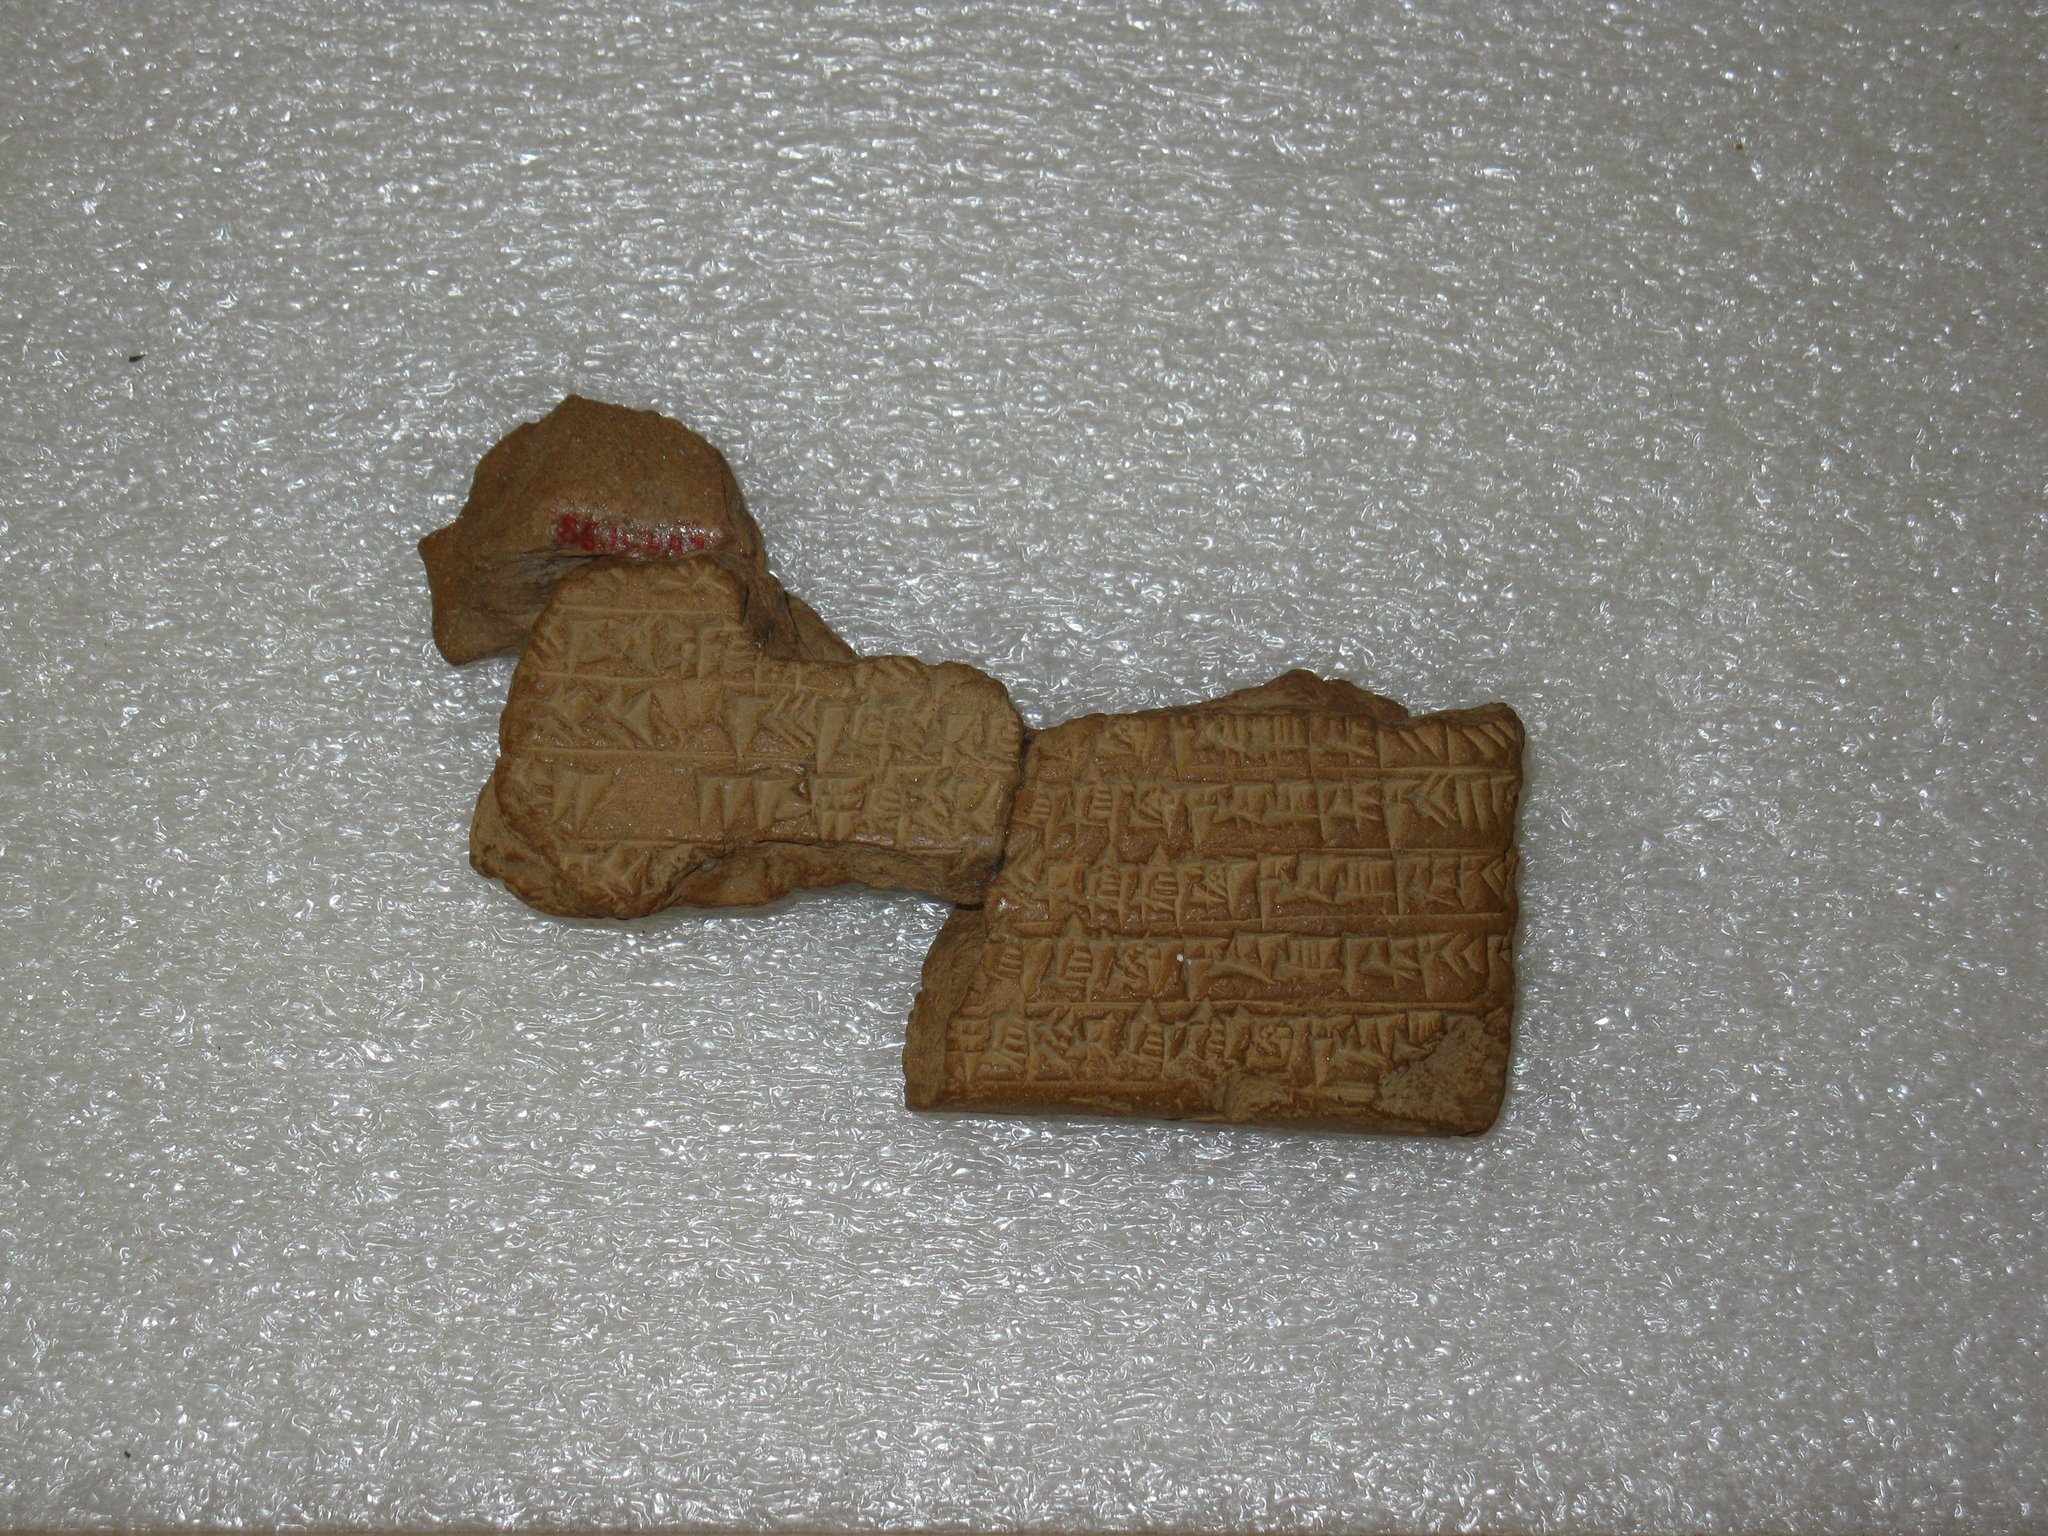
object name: cuneiform tablet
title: Cuneiform tablet: lunar procedure text (?)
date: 333-1 BCE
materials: clay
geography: mesopotamia